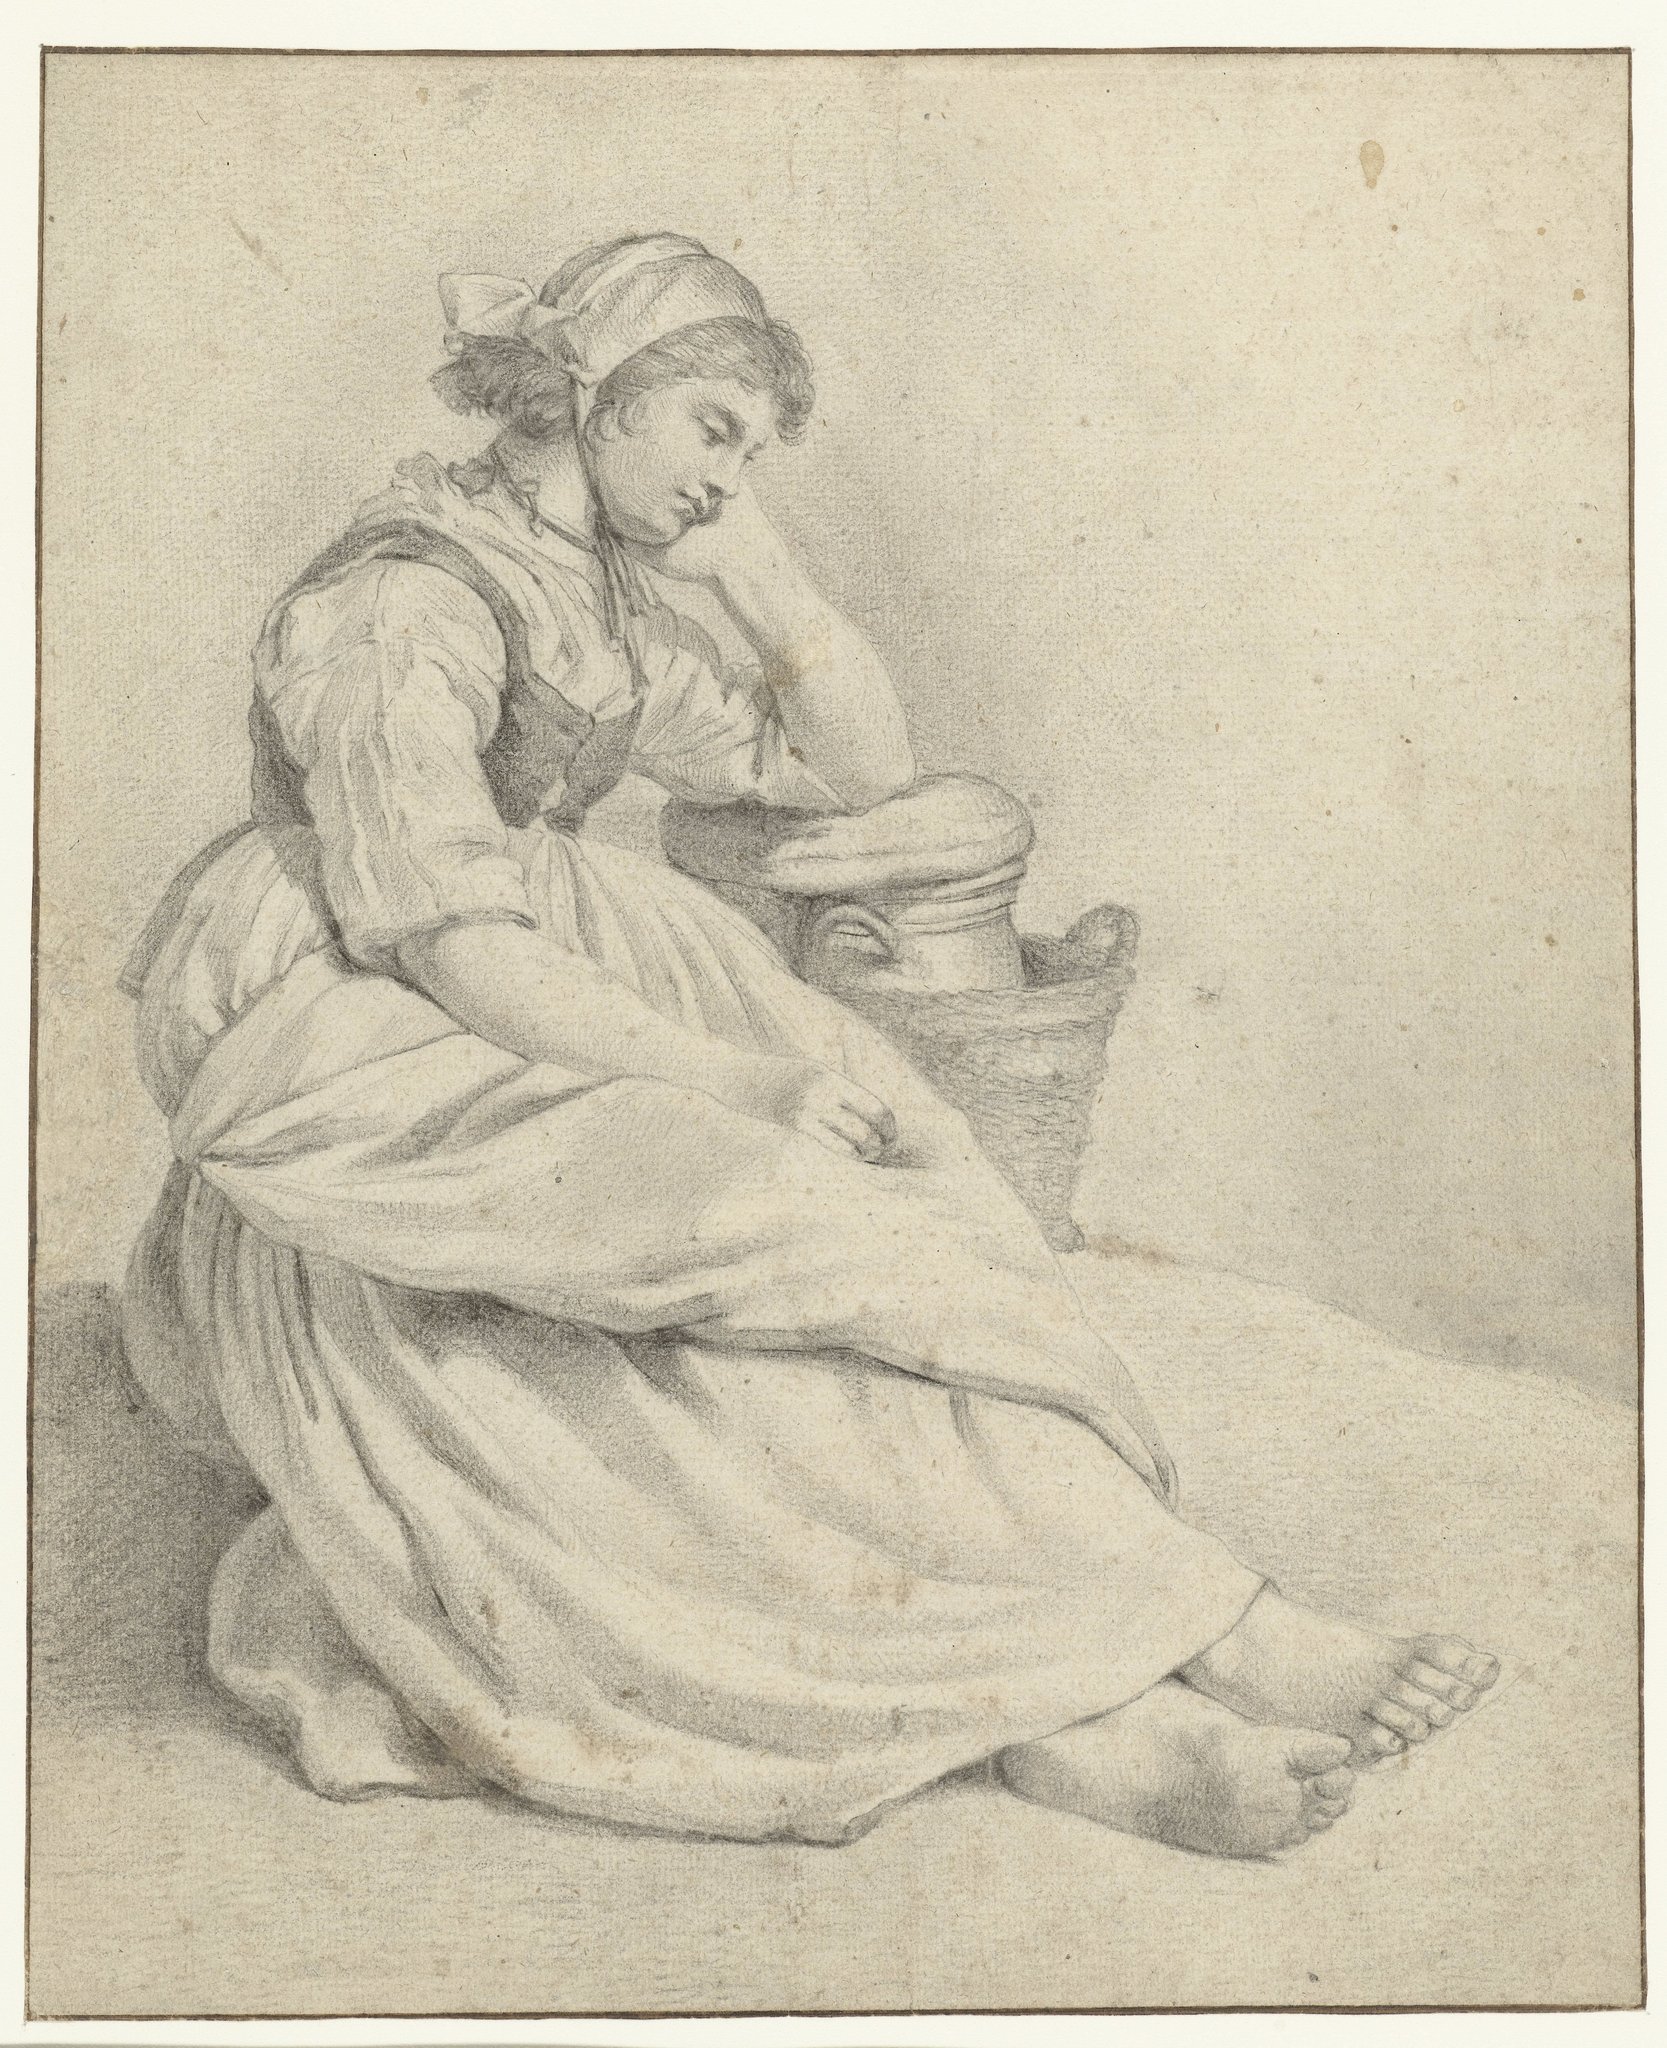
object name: drawing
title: Studie van een zittend meisje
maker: chrétien dubois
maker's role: draughtsman, print maker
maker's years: 1765-1837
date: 1775-1837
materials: chalk, paper